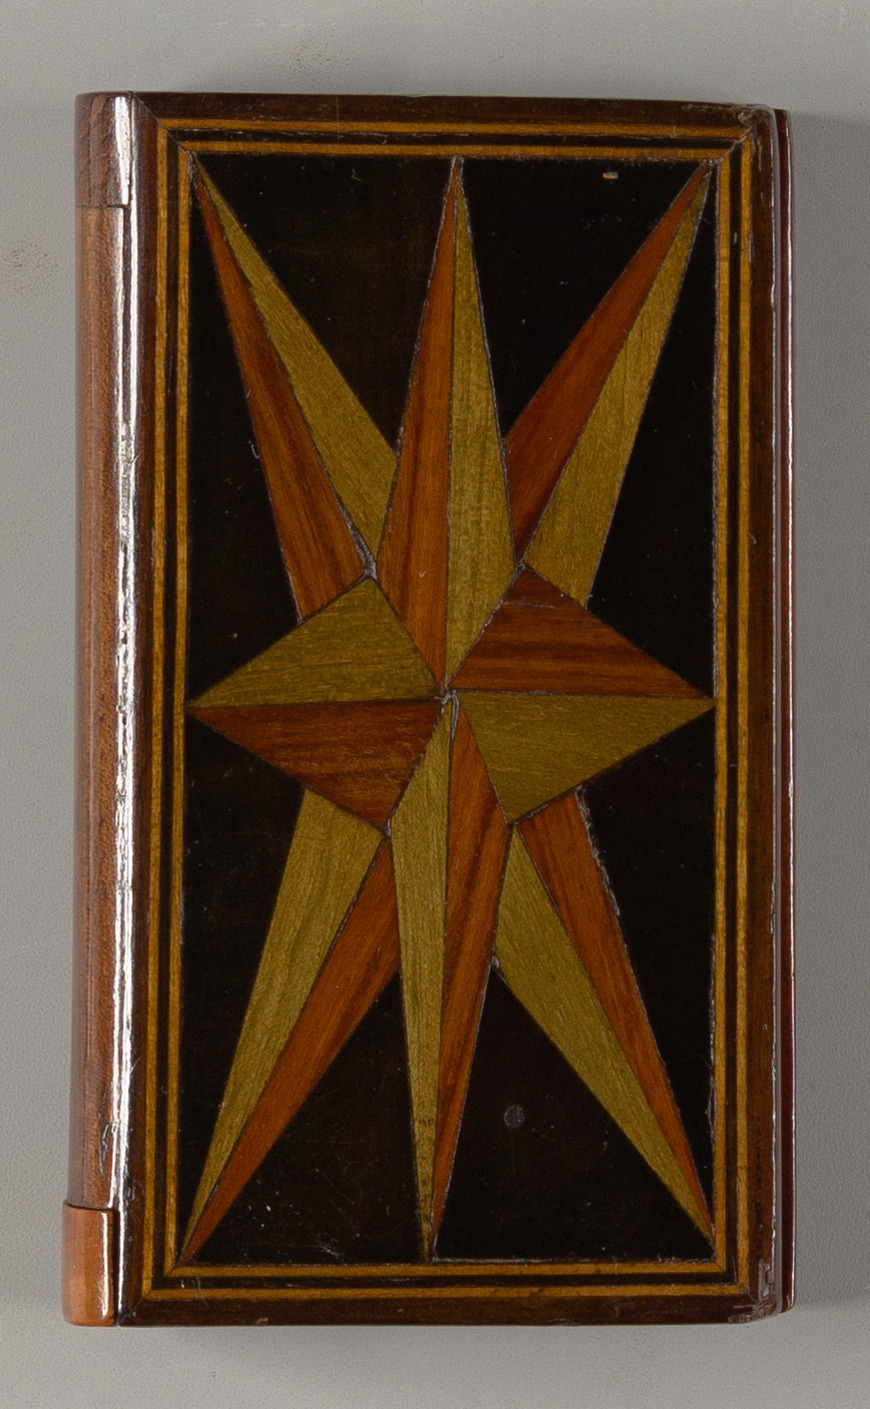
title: Marquetry box in book form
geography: england